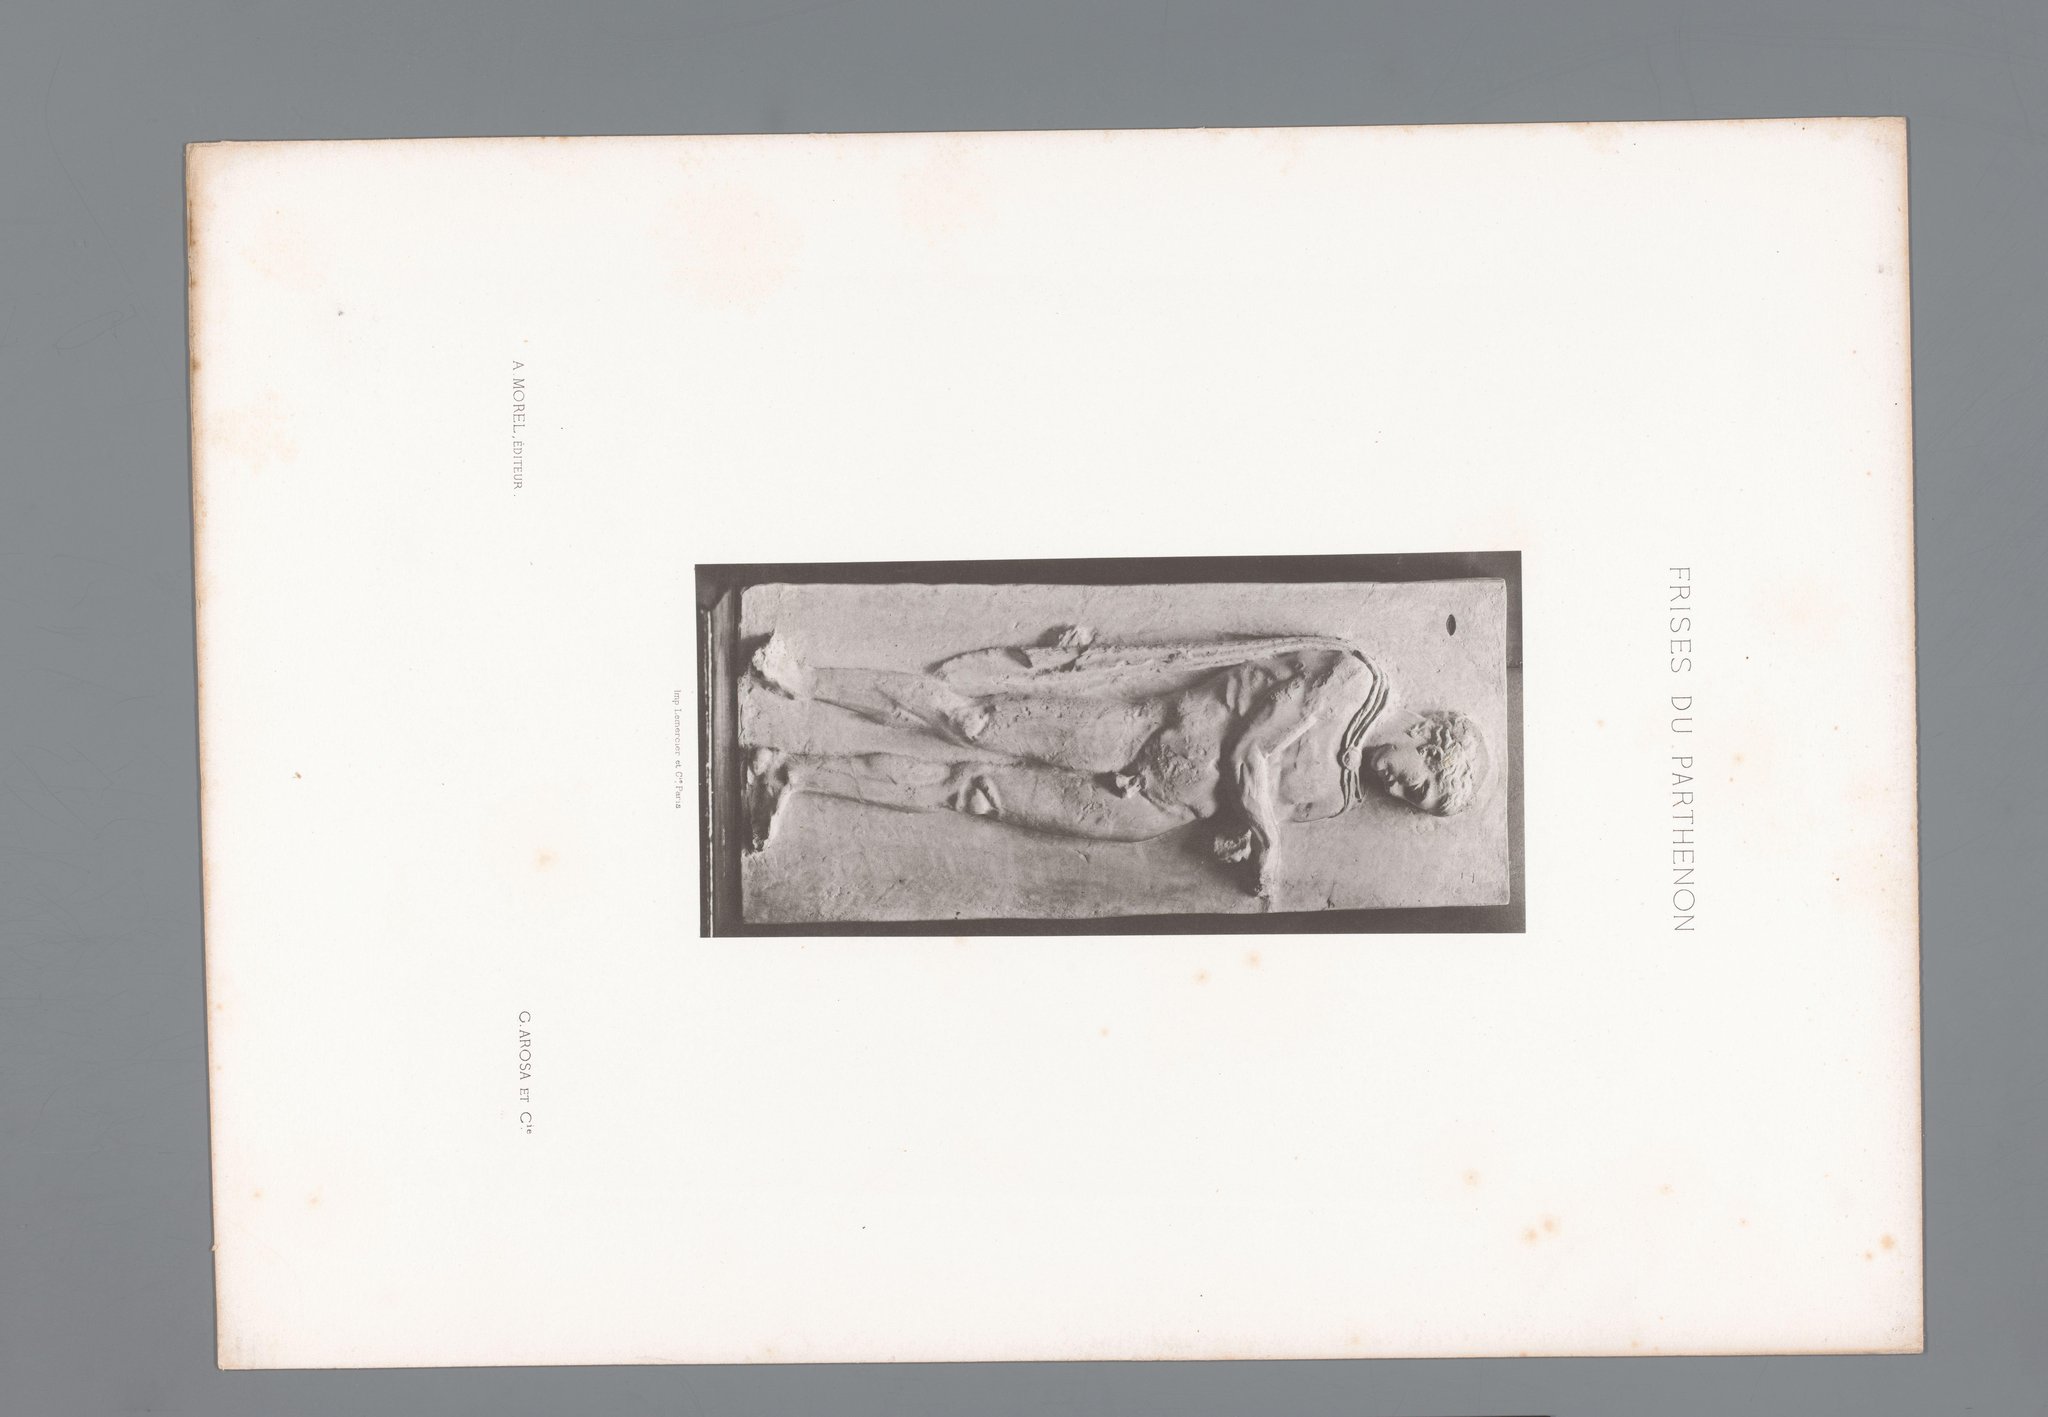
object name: photomechanical print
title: Deel van het fries van het Parthenon in Athene, afgebeeld een man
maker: a. morel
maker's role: publisher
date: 1863-1868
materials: paper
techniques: photograph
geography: paris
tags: mouldings ~ architecture, adult man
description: Deze prent maakt deel uit van een omslag met 22 prenten en 3 tekstbladen.